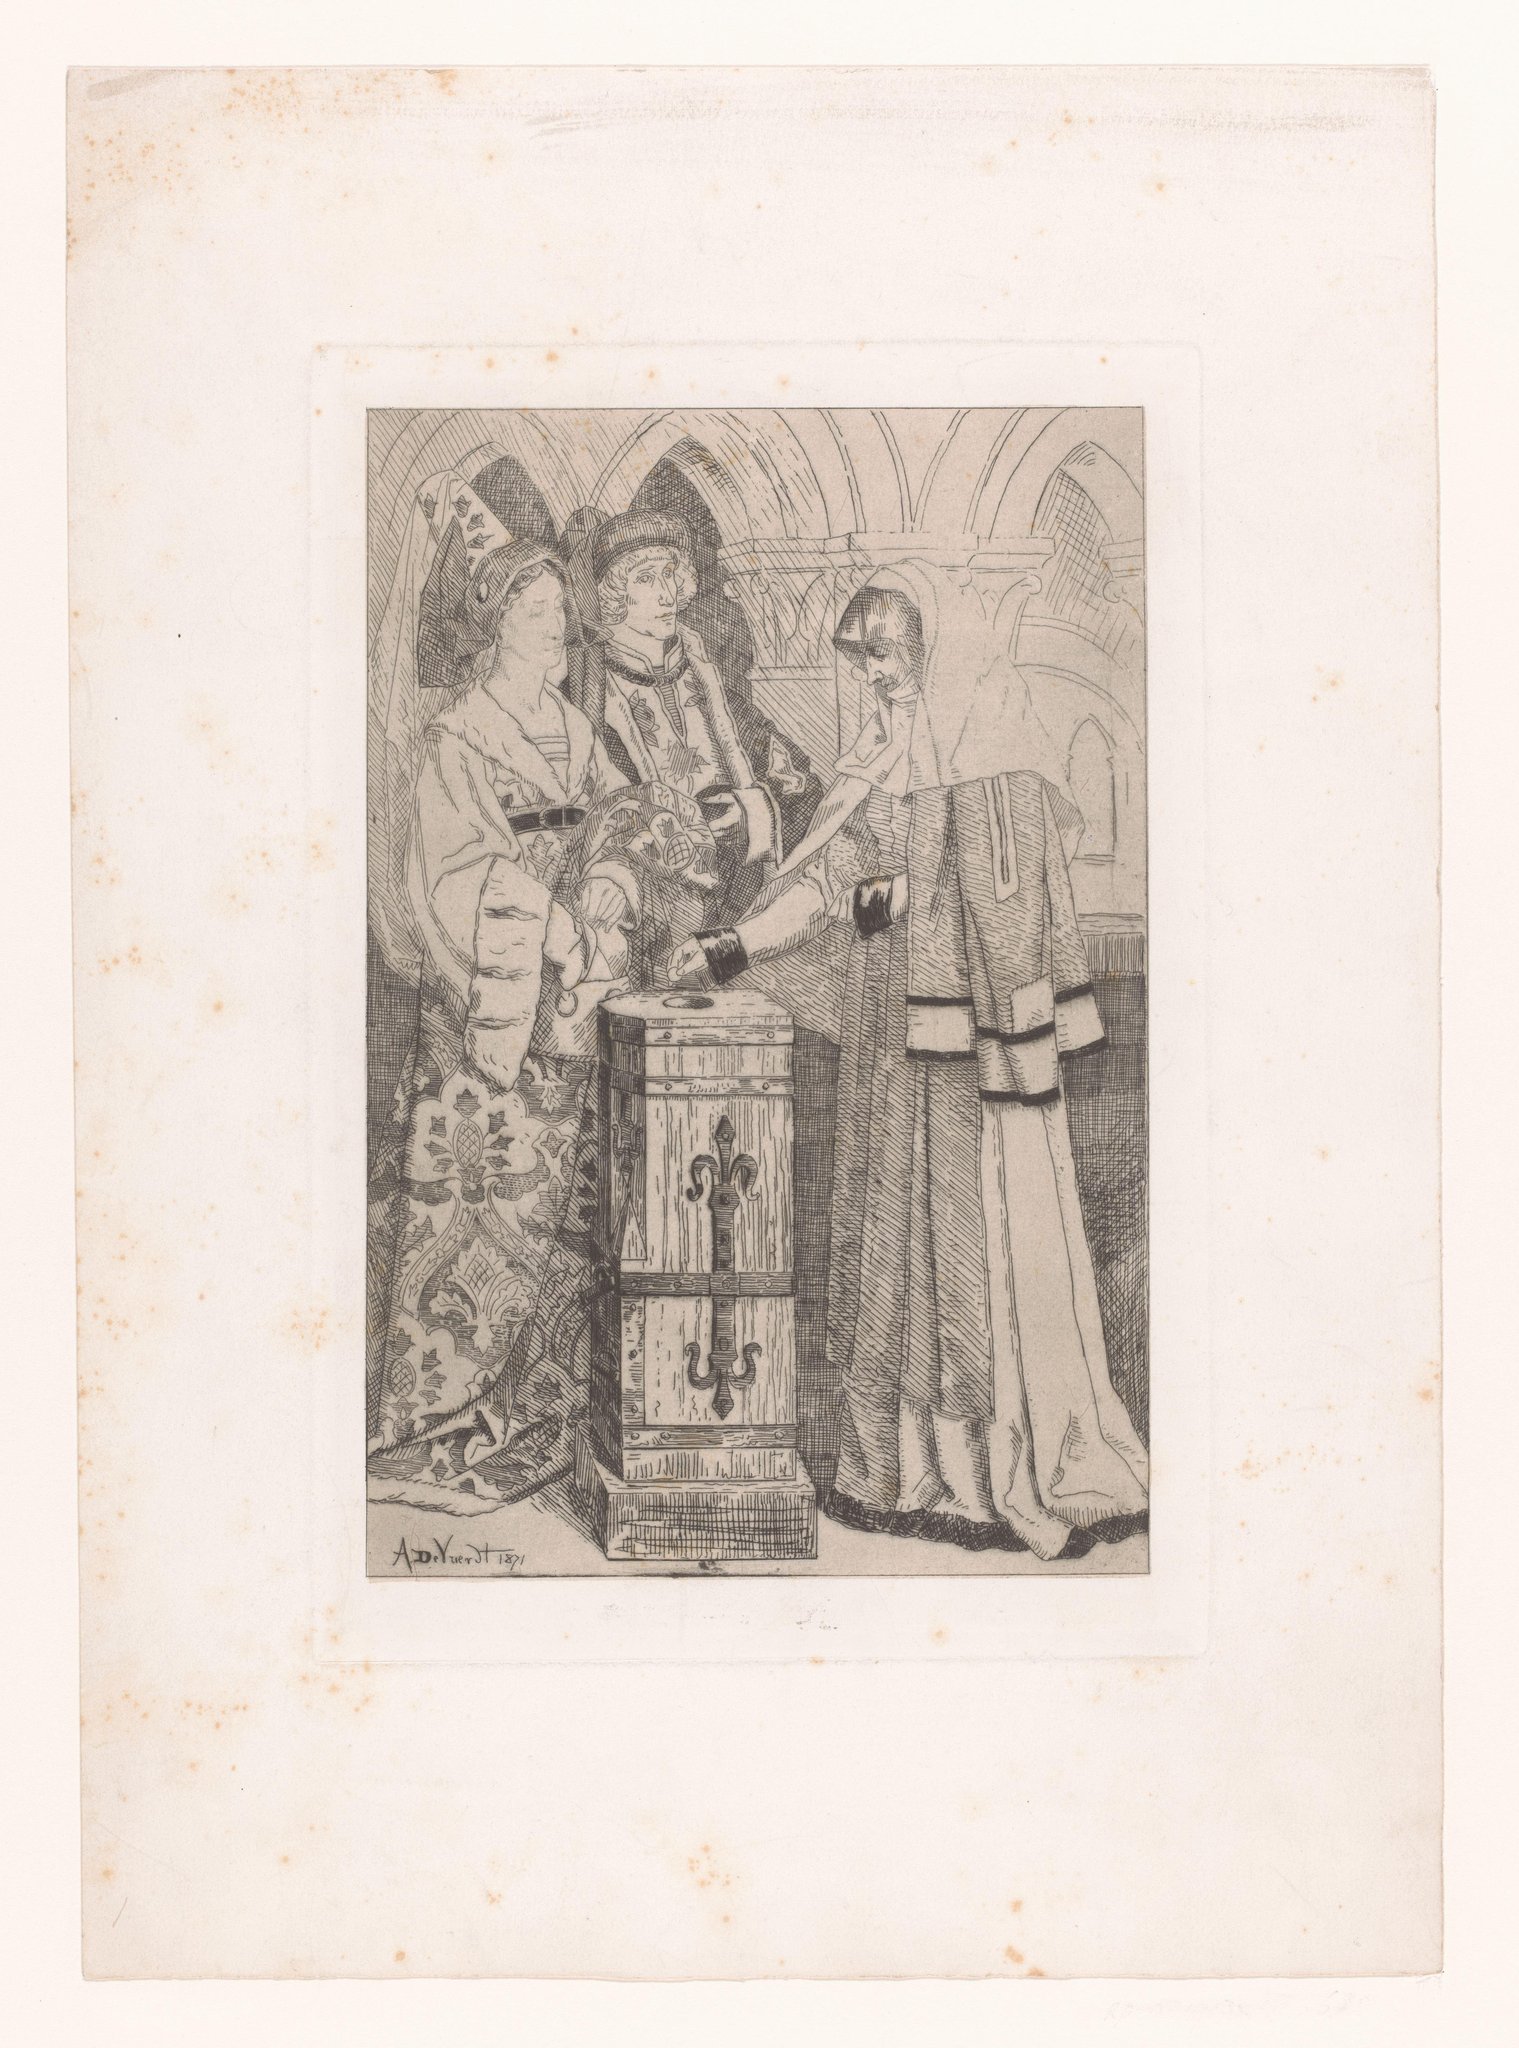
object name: print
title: Weduwe geeft een gift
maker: albrecht de vriendt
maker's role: print maker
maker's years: 1843-1900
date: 1871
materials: paper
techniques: etching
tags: offertory-box, offertory-bag, widow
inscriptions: collector's mark: Lugt 2228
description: Een latere staat van deze prent is verschenen in: Album du journal des Beaux-Arts, dix eaux-fortes inédites. Brussel: Decq et al., 1871. Op voorblad van de publicatie getiteld: De Penning der Weduwe.